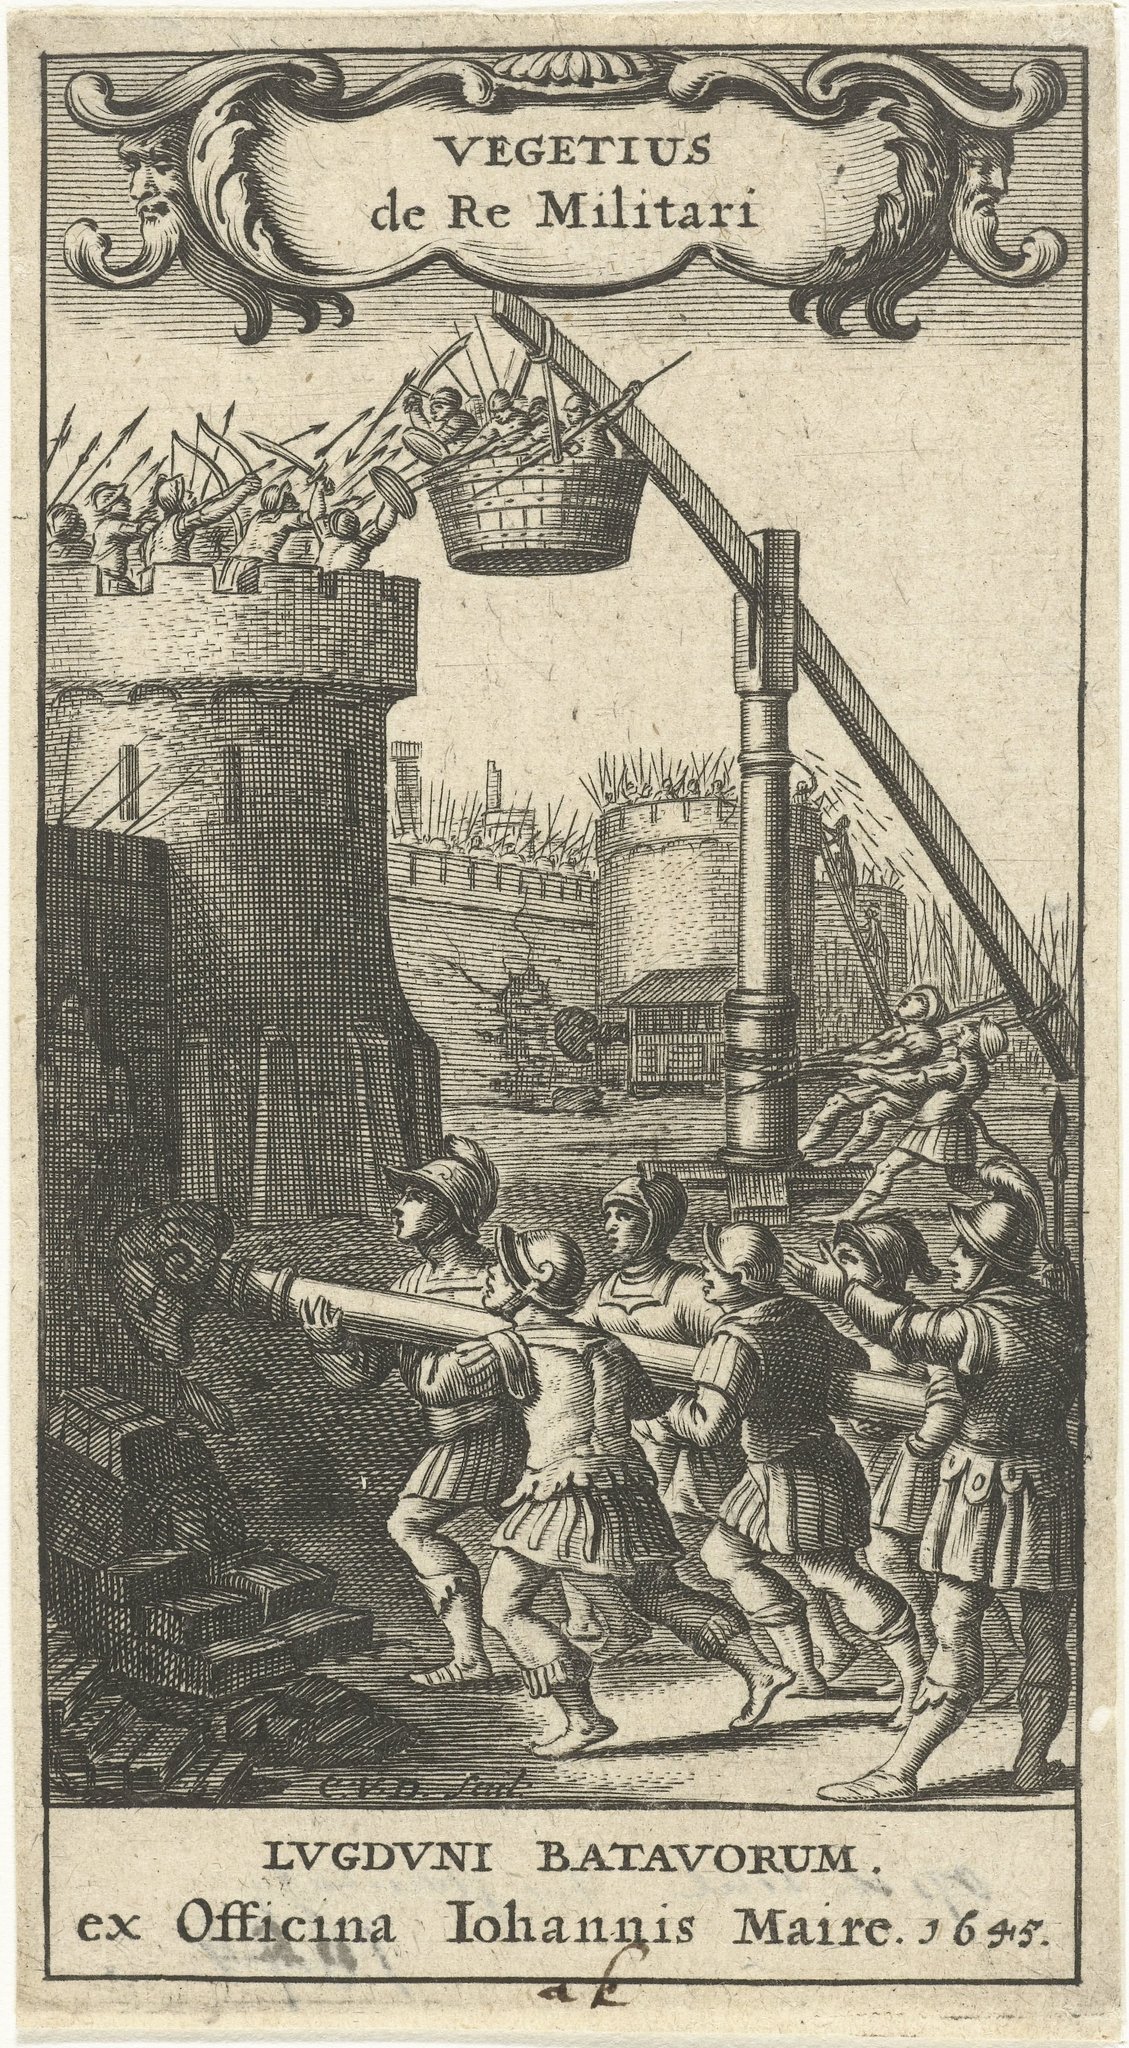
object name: print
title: De re militari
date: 1645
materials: paper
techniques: engraving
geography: amsterdam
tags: attack ~ siege, counter-attack from a fortification ~ siege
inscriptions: collector's mark: Lugt 2227, collector's mark: Lugt 2228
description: Titelpagina voor: Publius Flavius Vegetius Renatus, De re militari, Joannes Maire (uitgever), Leiden 1645